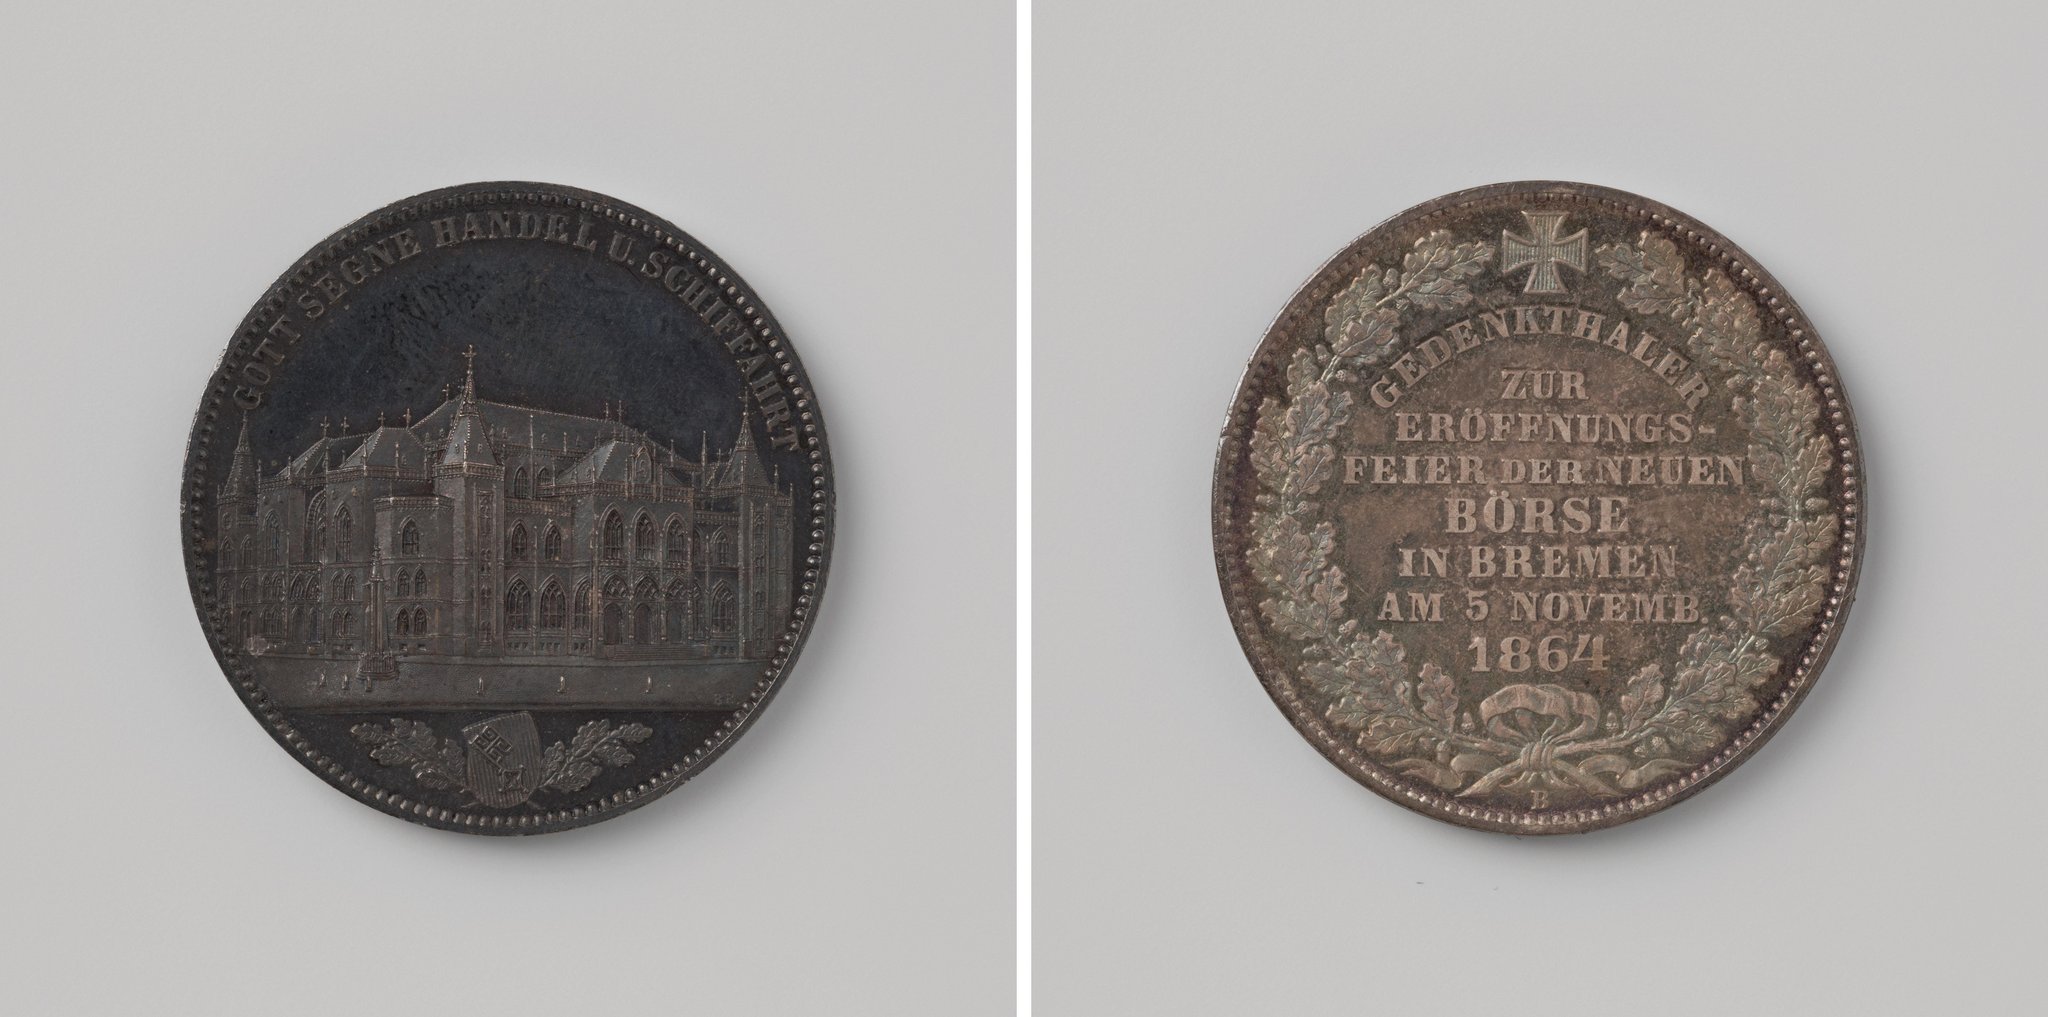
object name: coin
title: Taler over de opening van de beurs te Bremen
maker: monogrammist br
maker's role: medailleur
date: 1864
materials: silver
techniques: striking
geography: germany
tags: stock exchange, stock-market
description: Voorzijde: nieuwe beursgebouw binnen omschrift; afsnede: wapenschild op twee gekruiste eiketakken. Keerzijde: opschrift onder kruis binnen eikekrans